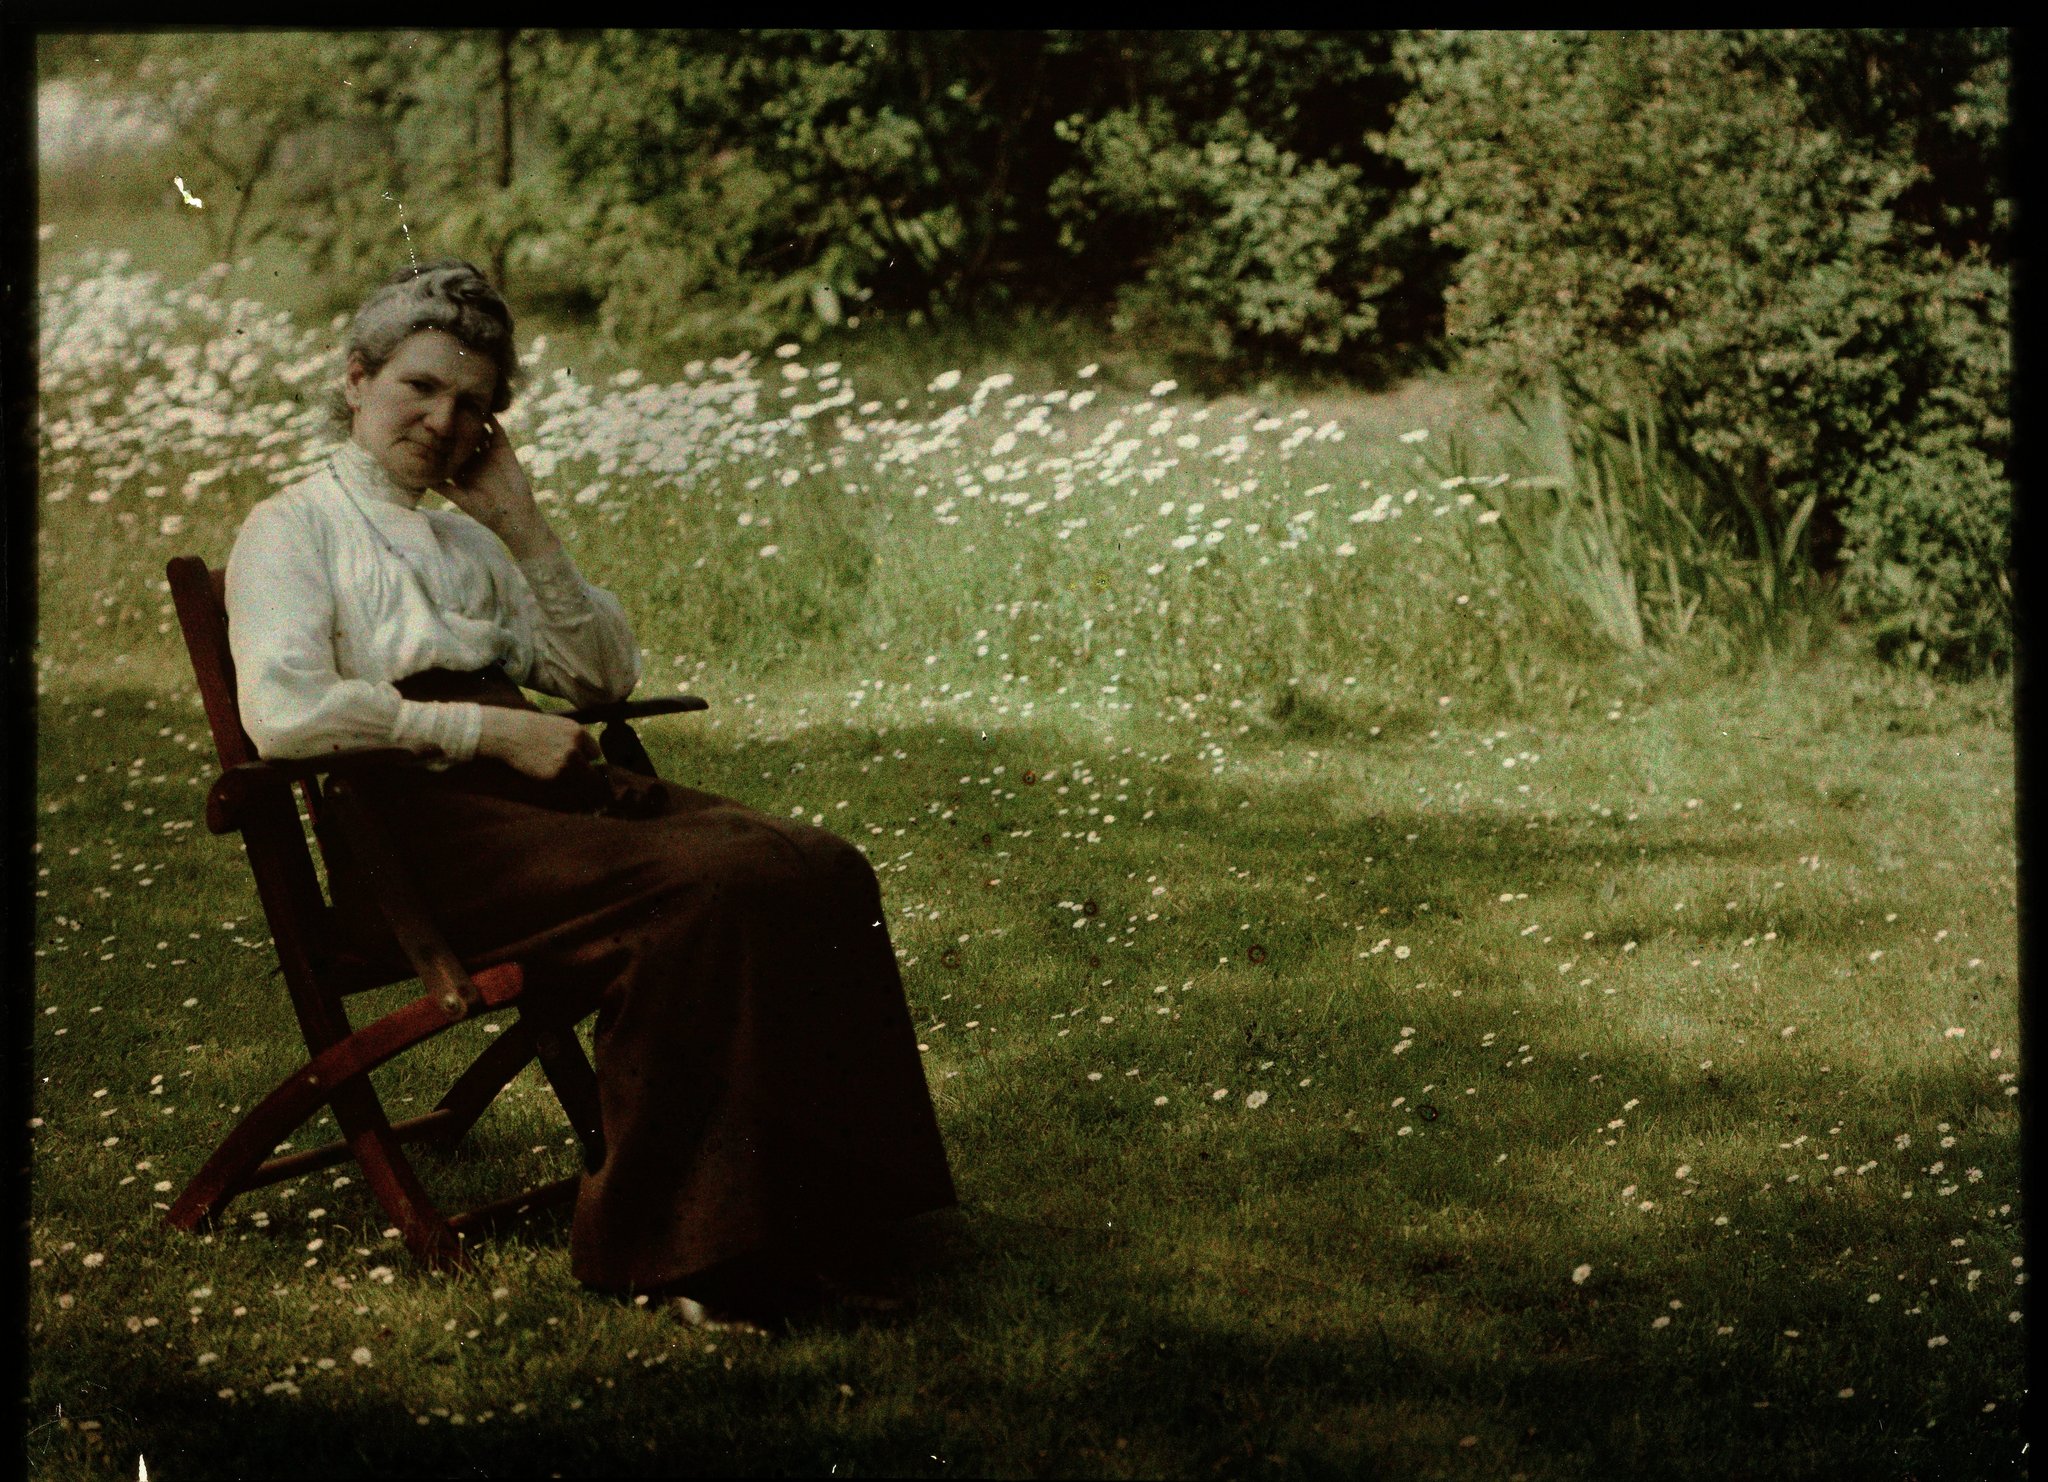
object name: photograph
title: Oudere vrouw (gekleed in een witte blouse en een donkere rok) zittend in een stoel op een grasveld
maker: adolphe burdet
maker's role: fotograaf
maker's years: 1860-1940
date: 1907-1930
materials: glass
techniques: autochrome process, slide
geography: netherlands